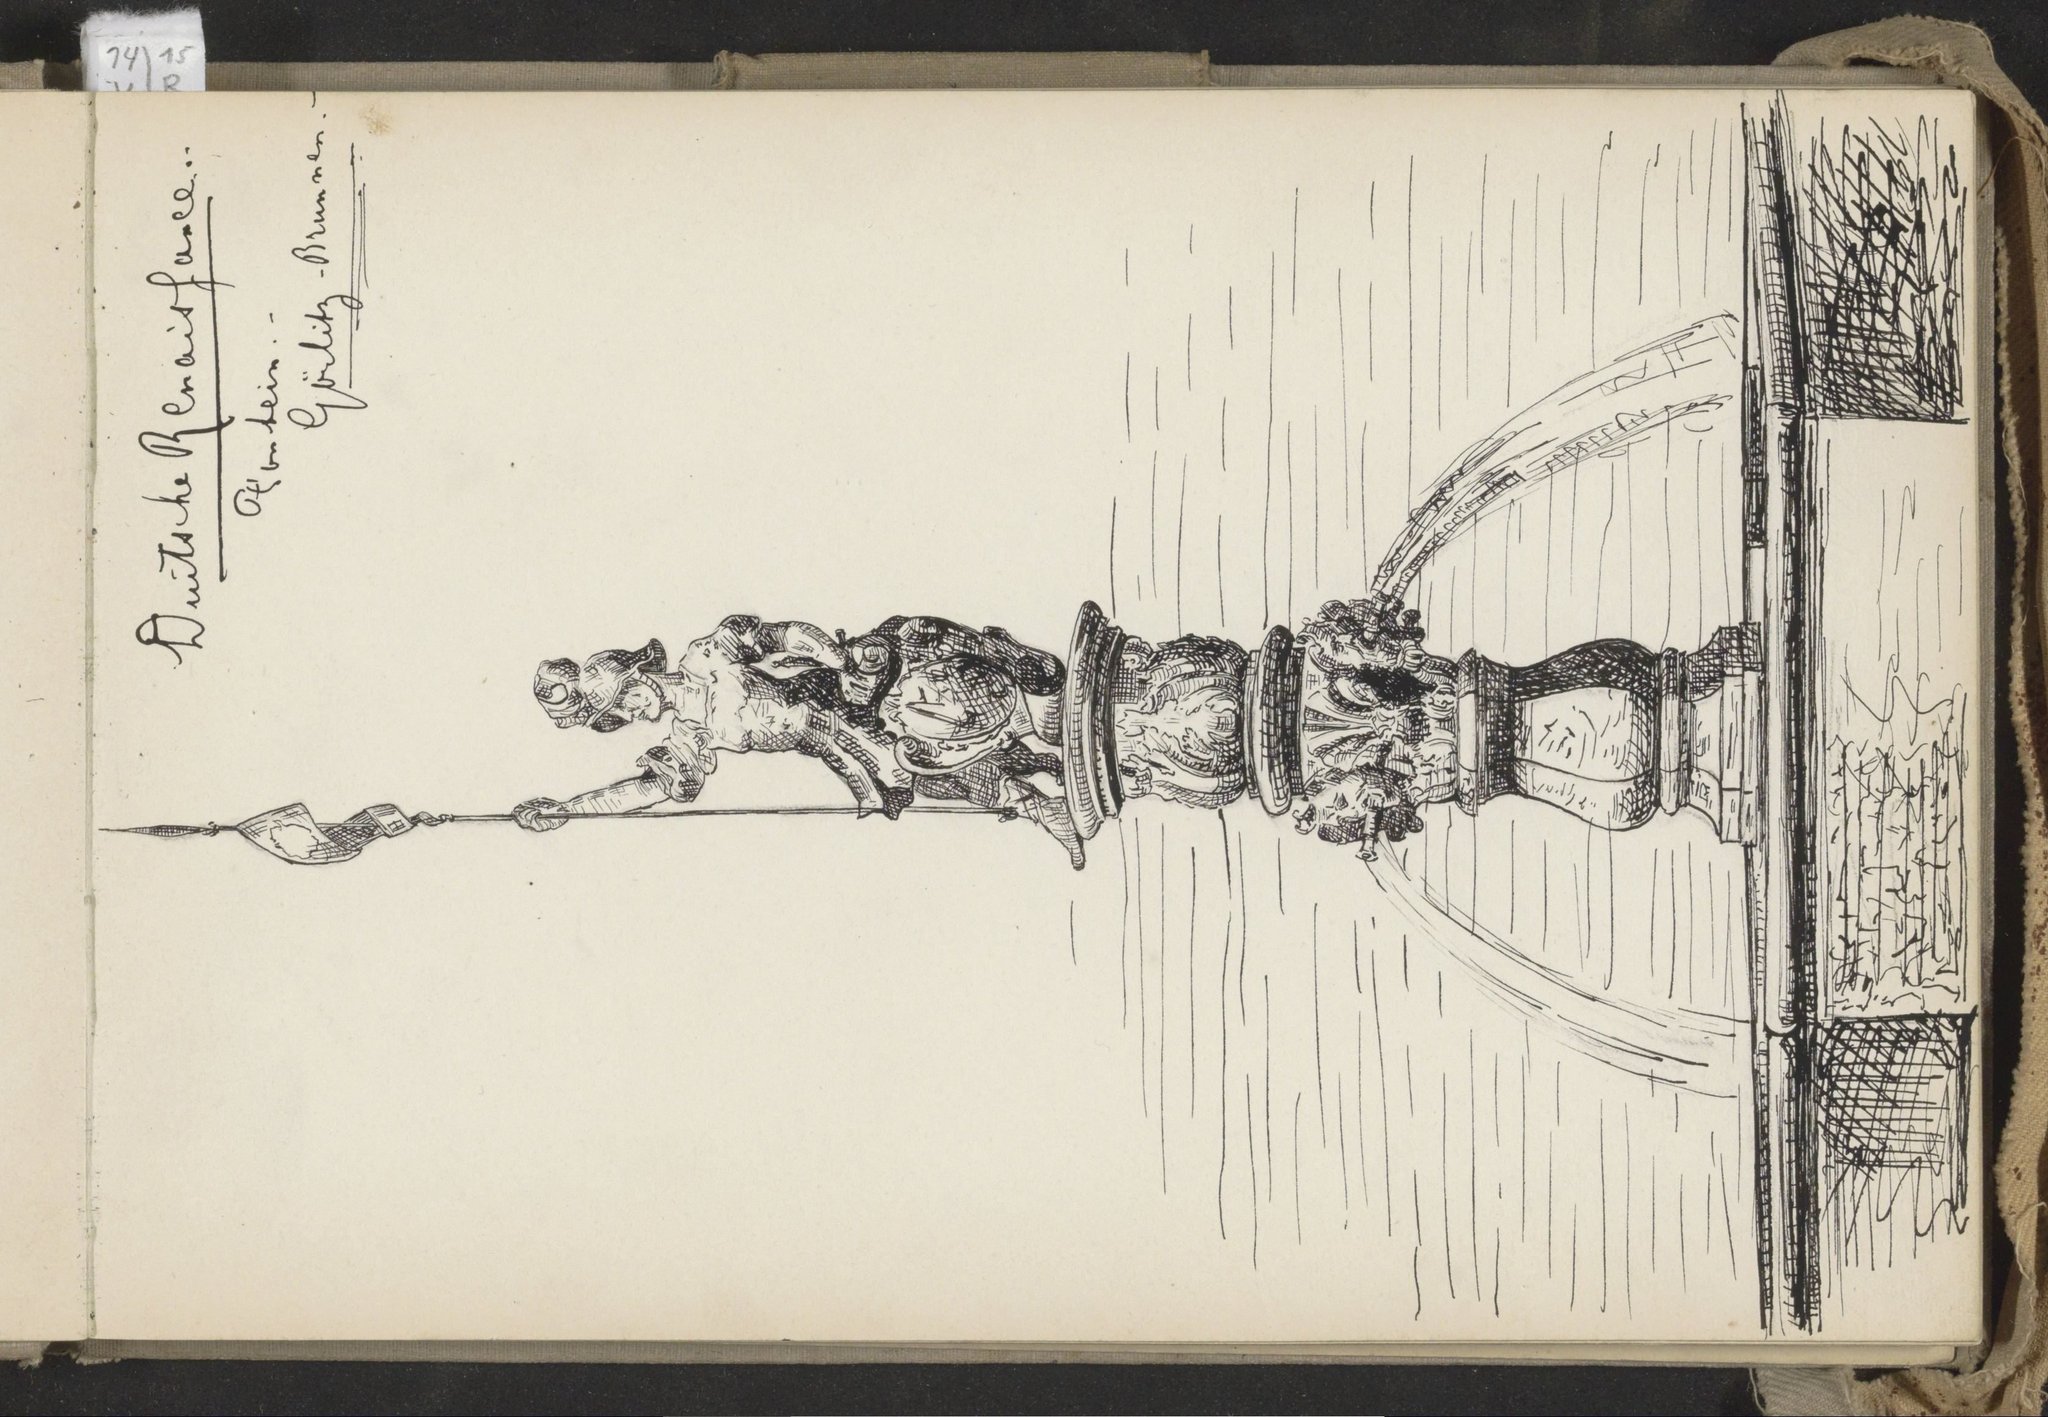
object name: sketchbook leaf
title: Georgsbrunnen op de Obermarkt te Görlitz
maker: johanna van de kamer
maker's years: 1873-1922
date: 1890-1922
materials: ink, paper, pencil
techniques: pen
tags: ornamental fountain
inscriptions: annotation: ‘Duitsche Renaissance./ Fontein/ Görlitz Brunnen.-’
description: De figuur in ridderkostuum op de fontein draagt het Saksische wapen. Blad 14 recto uit een schetsboek met 49 bladen.